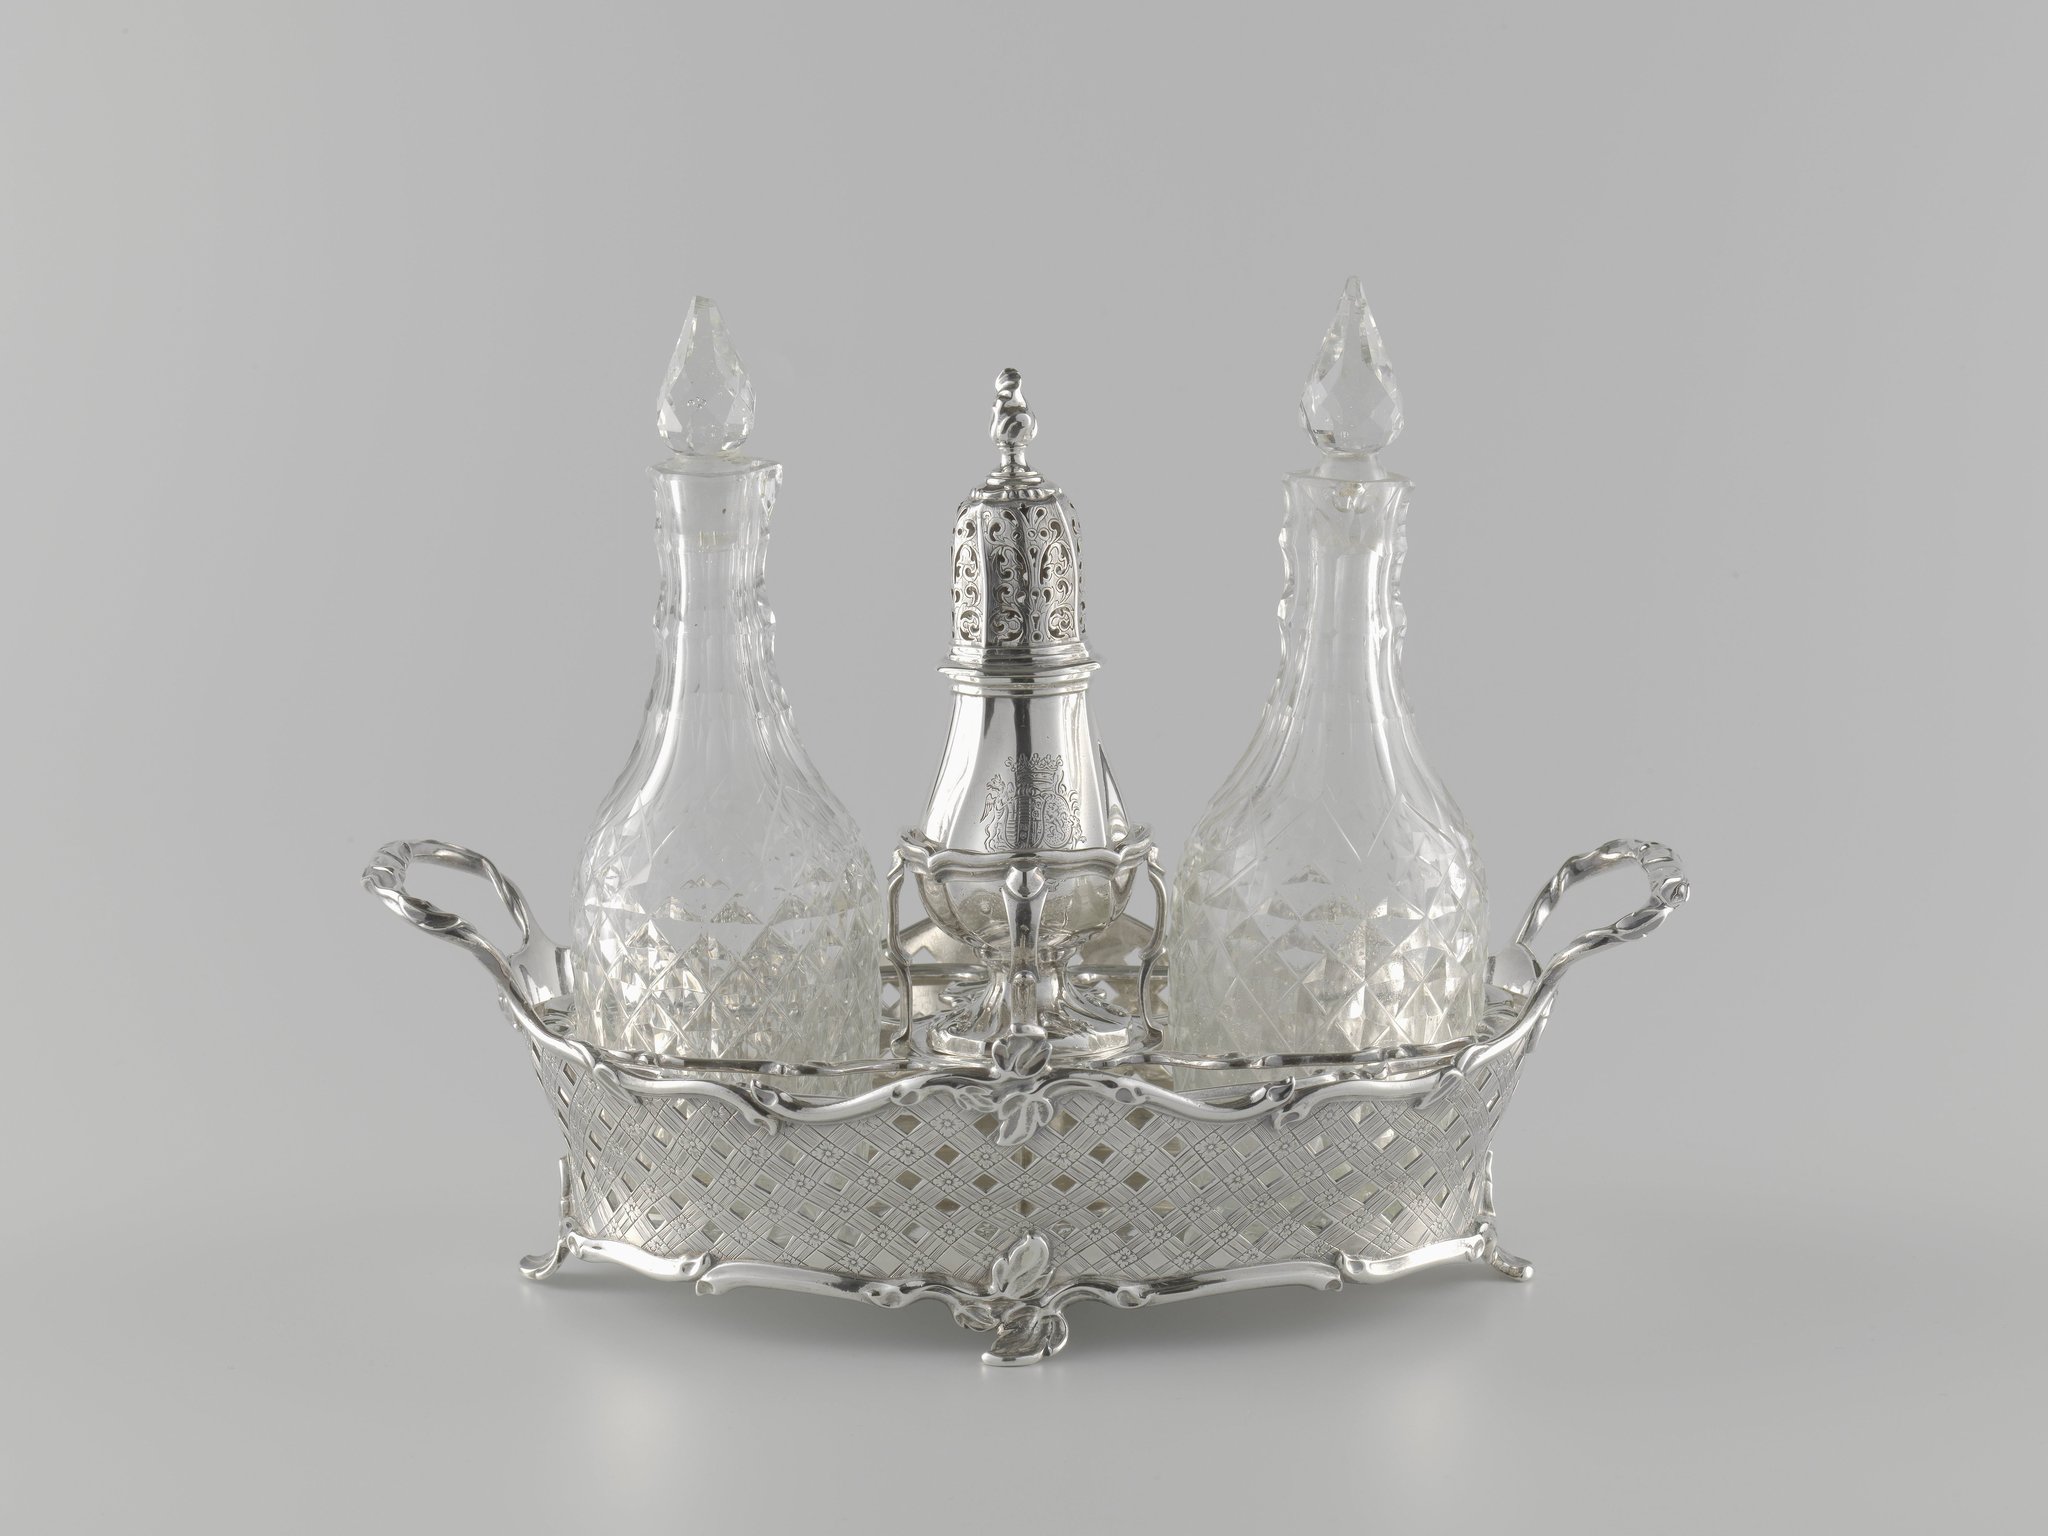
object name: cruet set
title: Olie- en azijnstel van zilver met twee kristallen flacons en een zilveren strooibus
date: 1767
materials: crystal, silver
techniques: casting, engraving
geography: the hague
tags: foliage, tendrils, branches ~ ornament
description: Cruet set. Silver and cut-glass. The Hague, 1767, by Isacq Samuel Bussard.